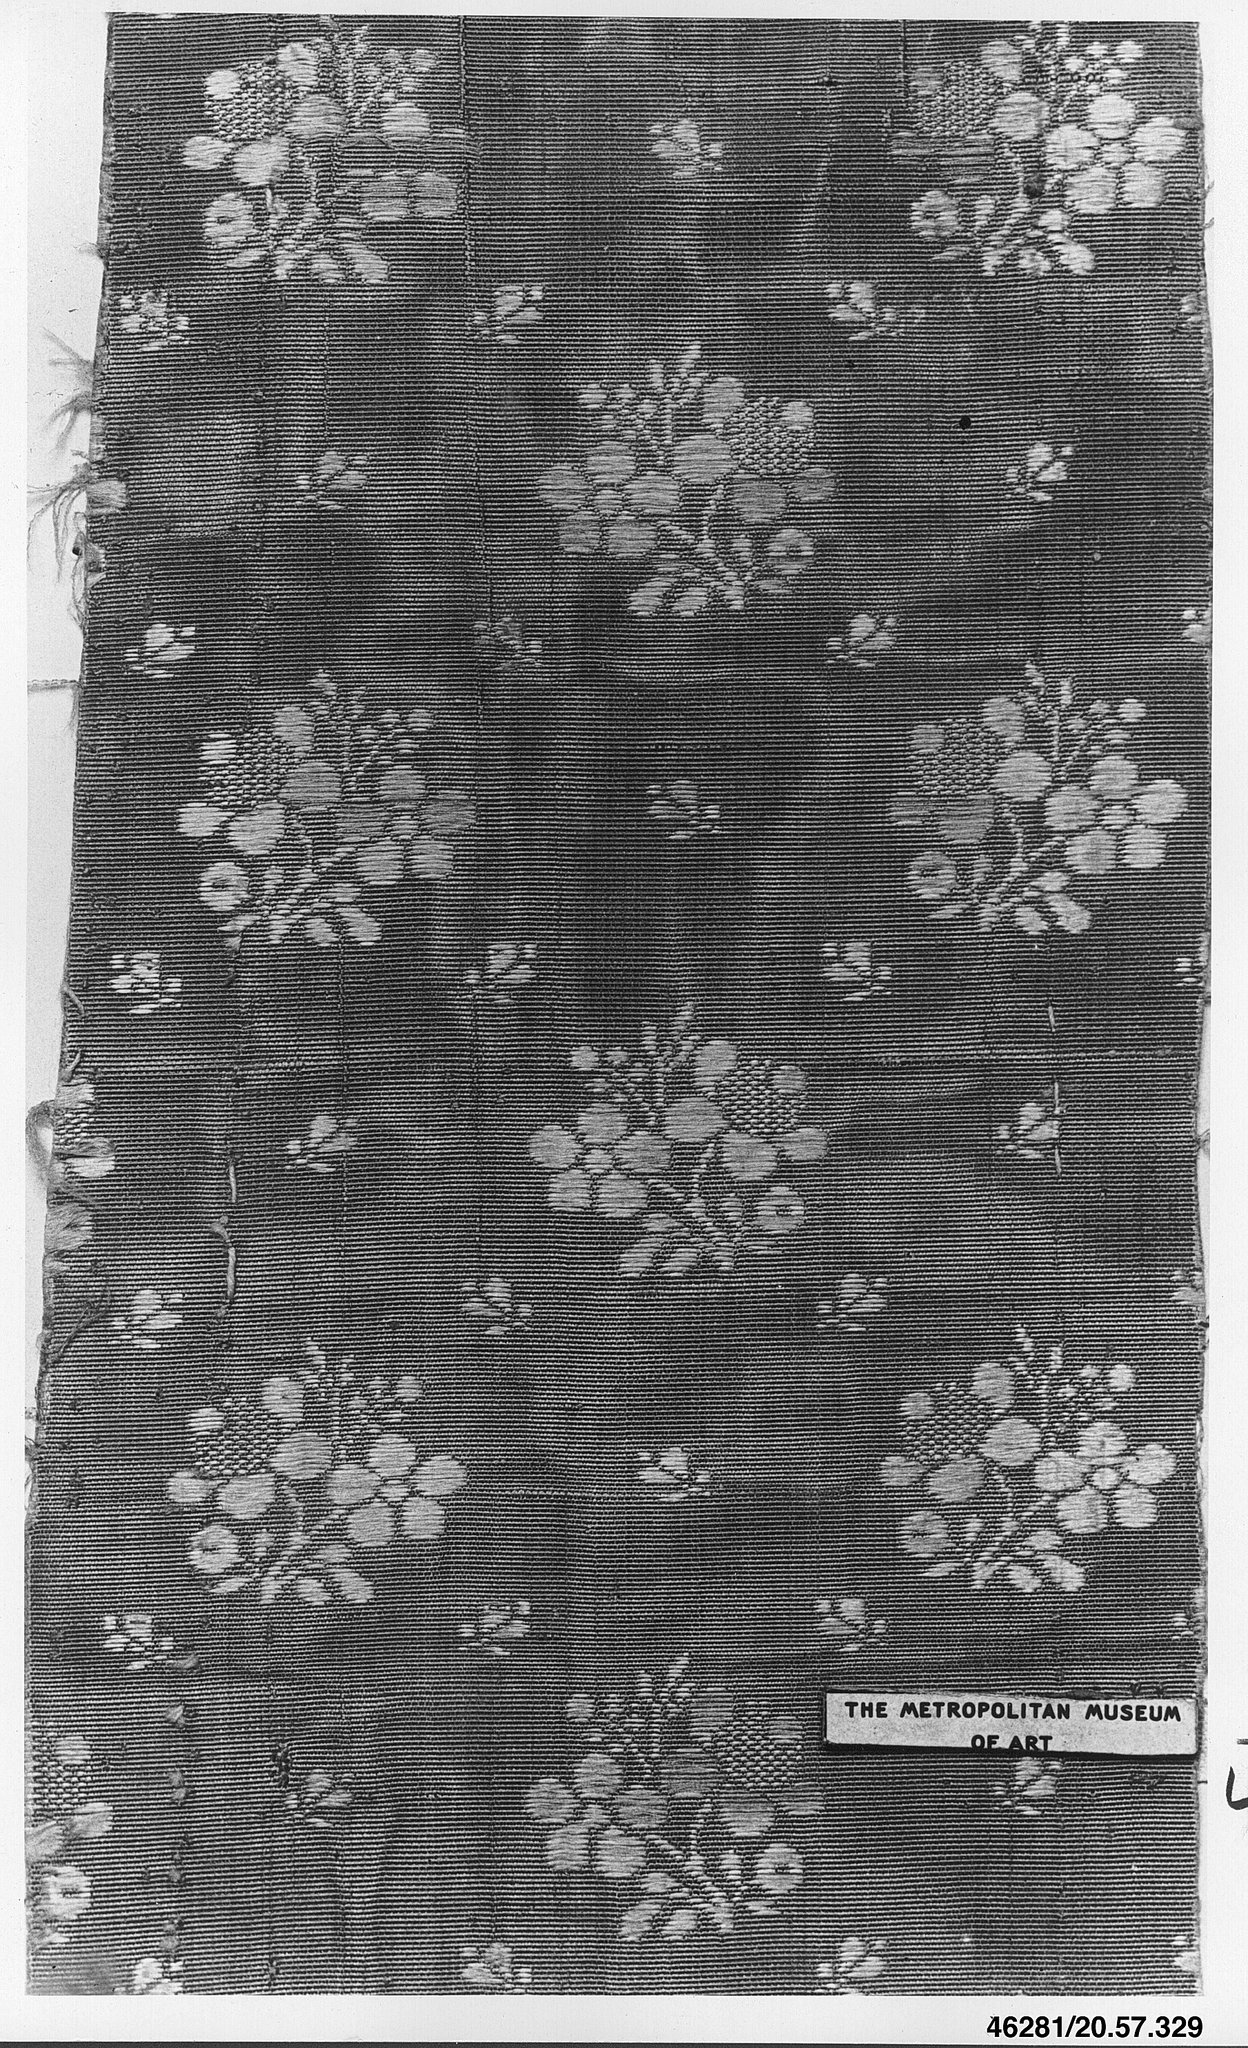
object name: piece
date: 1701-1800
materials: silk